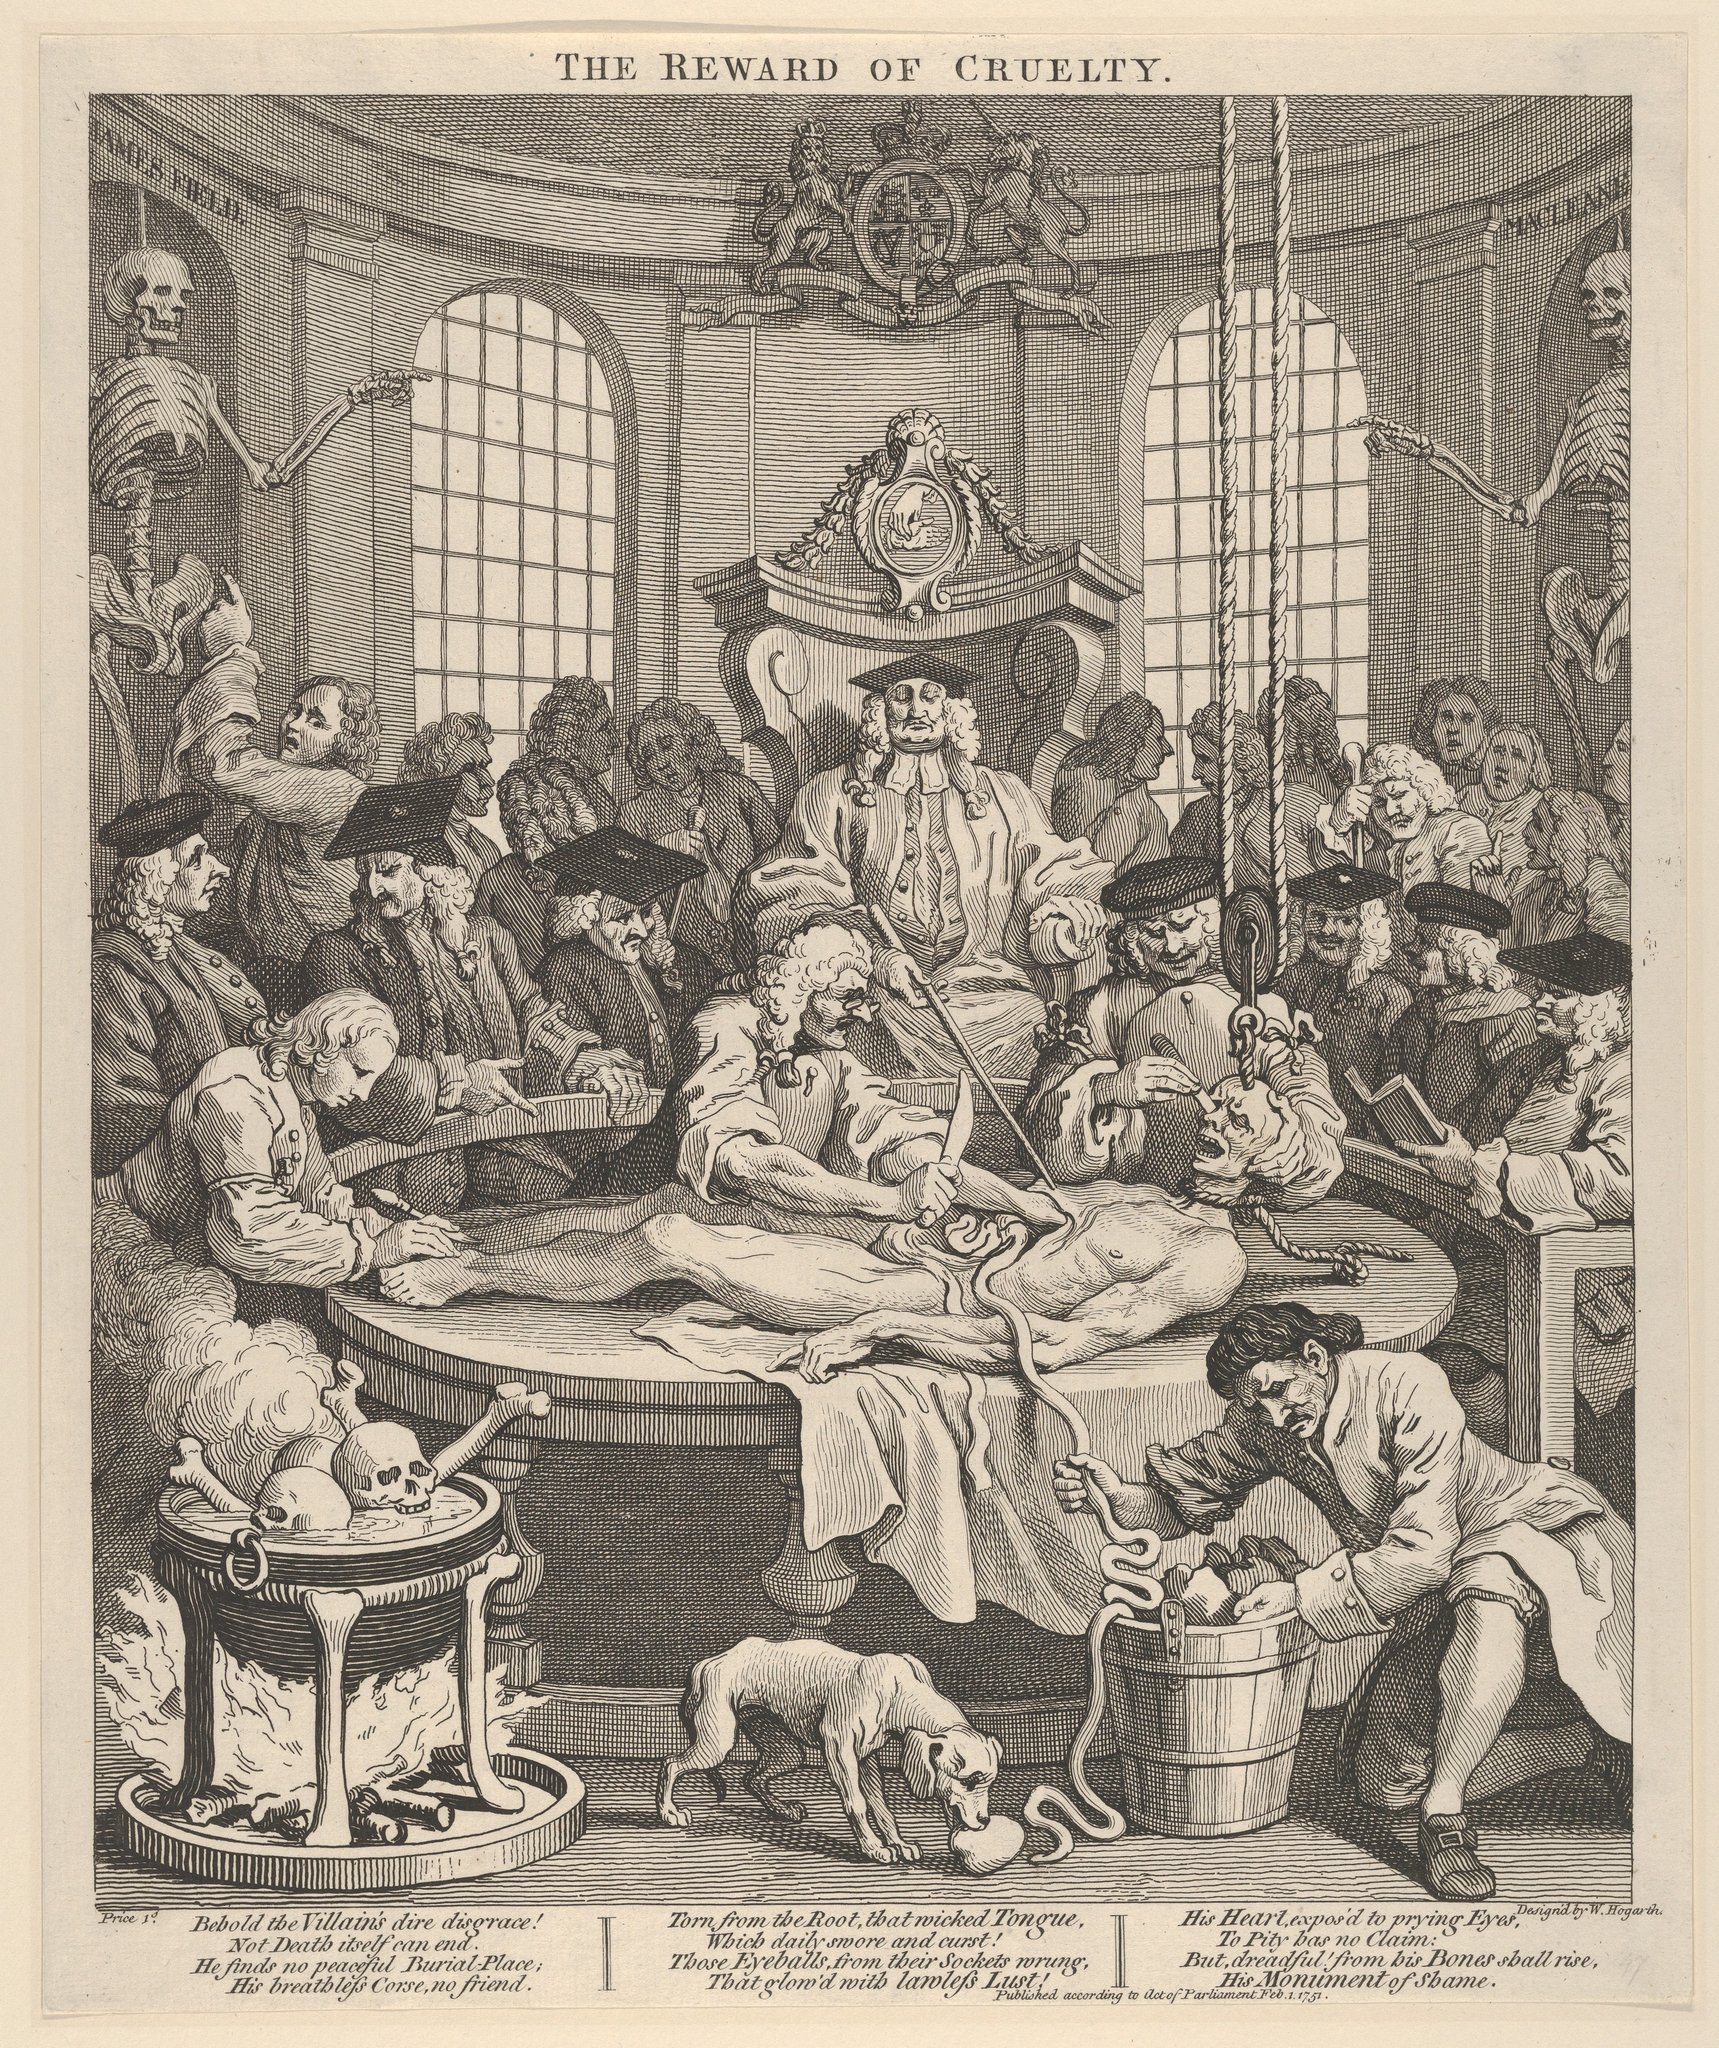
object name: print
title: The Reward of Cruelty (The Four Stages of Cruelty)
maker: william hogarth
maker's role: artist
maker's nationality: british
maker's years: 1697-1764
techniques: engraving, etching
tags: skeletons,skulls,men,dogs